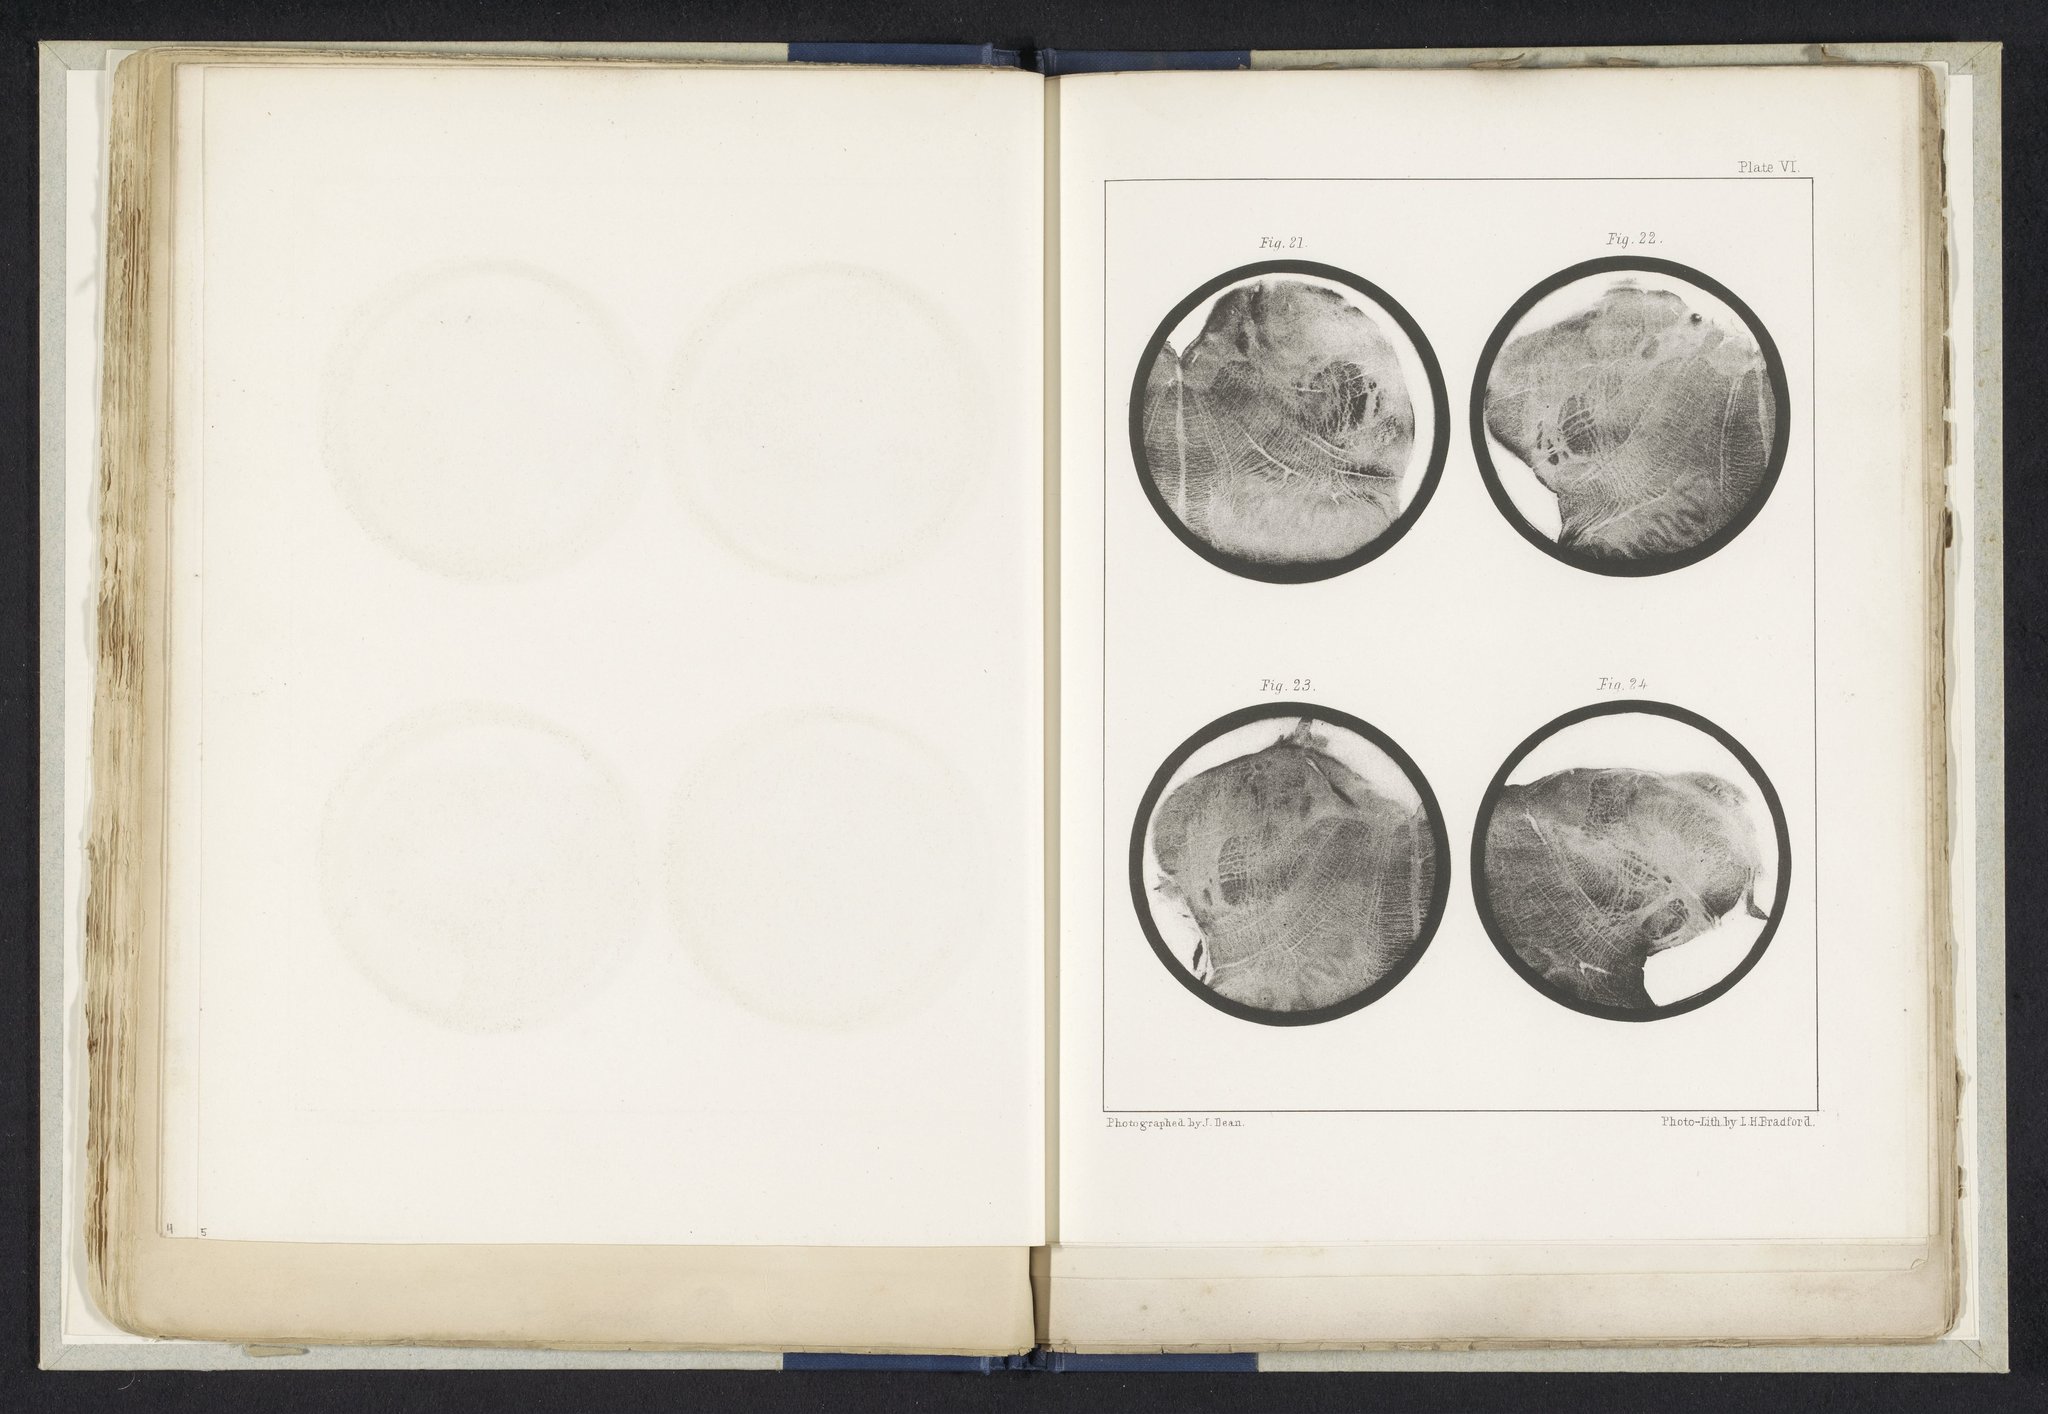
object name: page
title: Vier details van een medulla oblongata van een mens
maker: john dean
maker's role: fotograaf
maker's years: 1831-1888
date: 1854-1864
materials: paper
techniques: photolithography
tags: brains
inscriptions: number: ‘Plate VI. Fig. 21. Fig 22. Fig. 23. Fig. 24.’